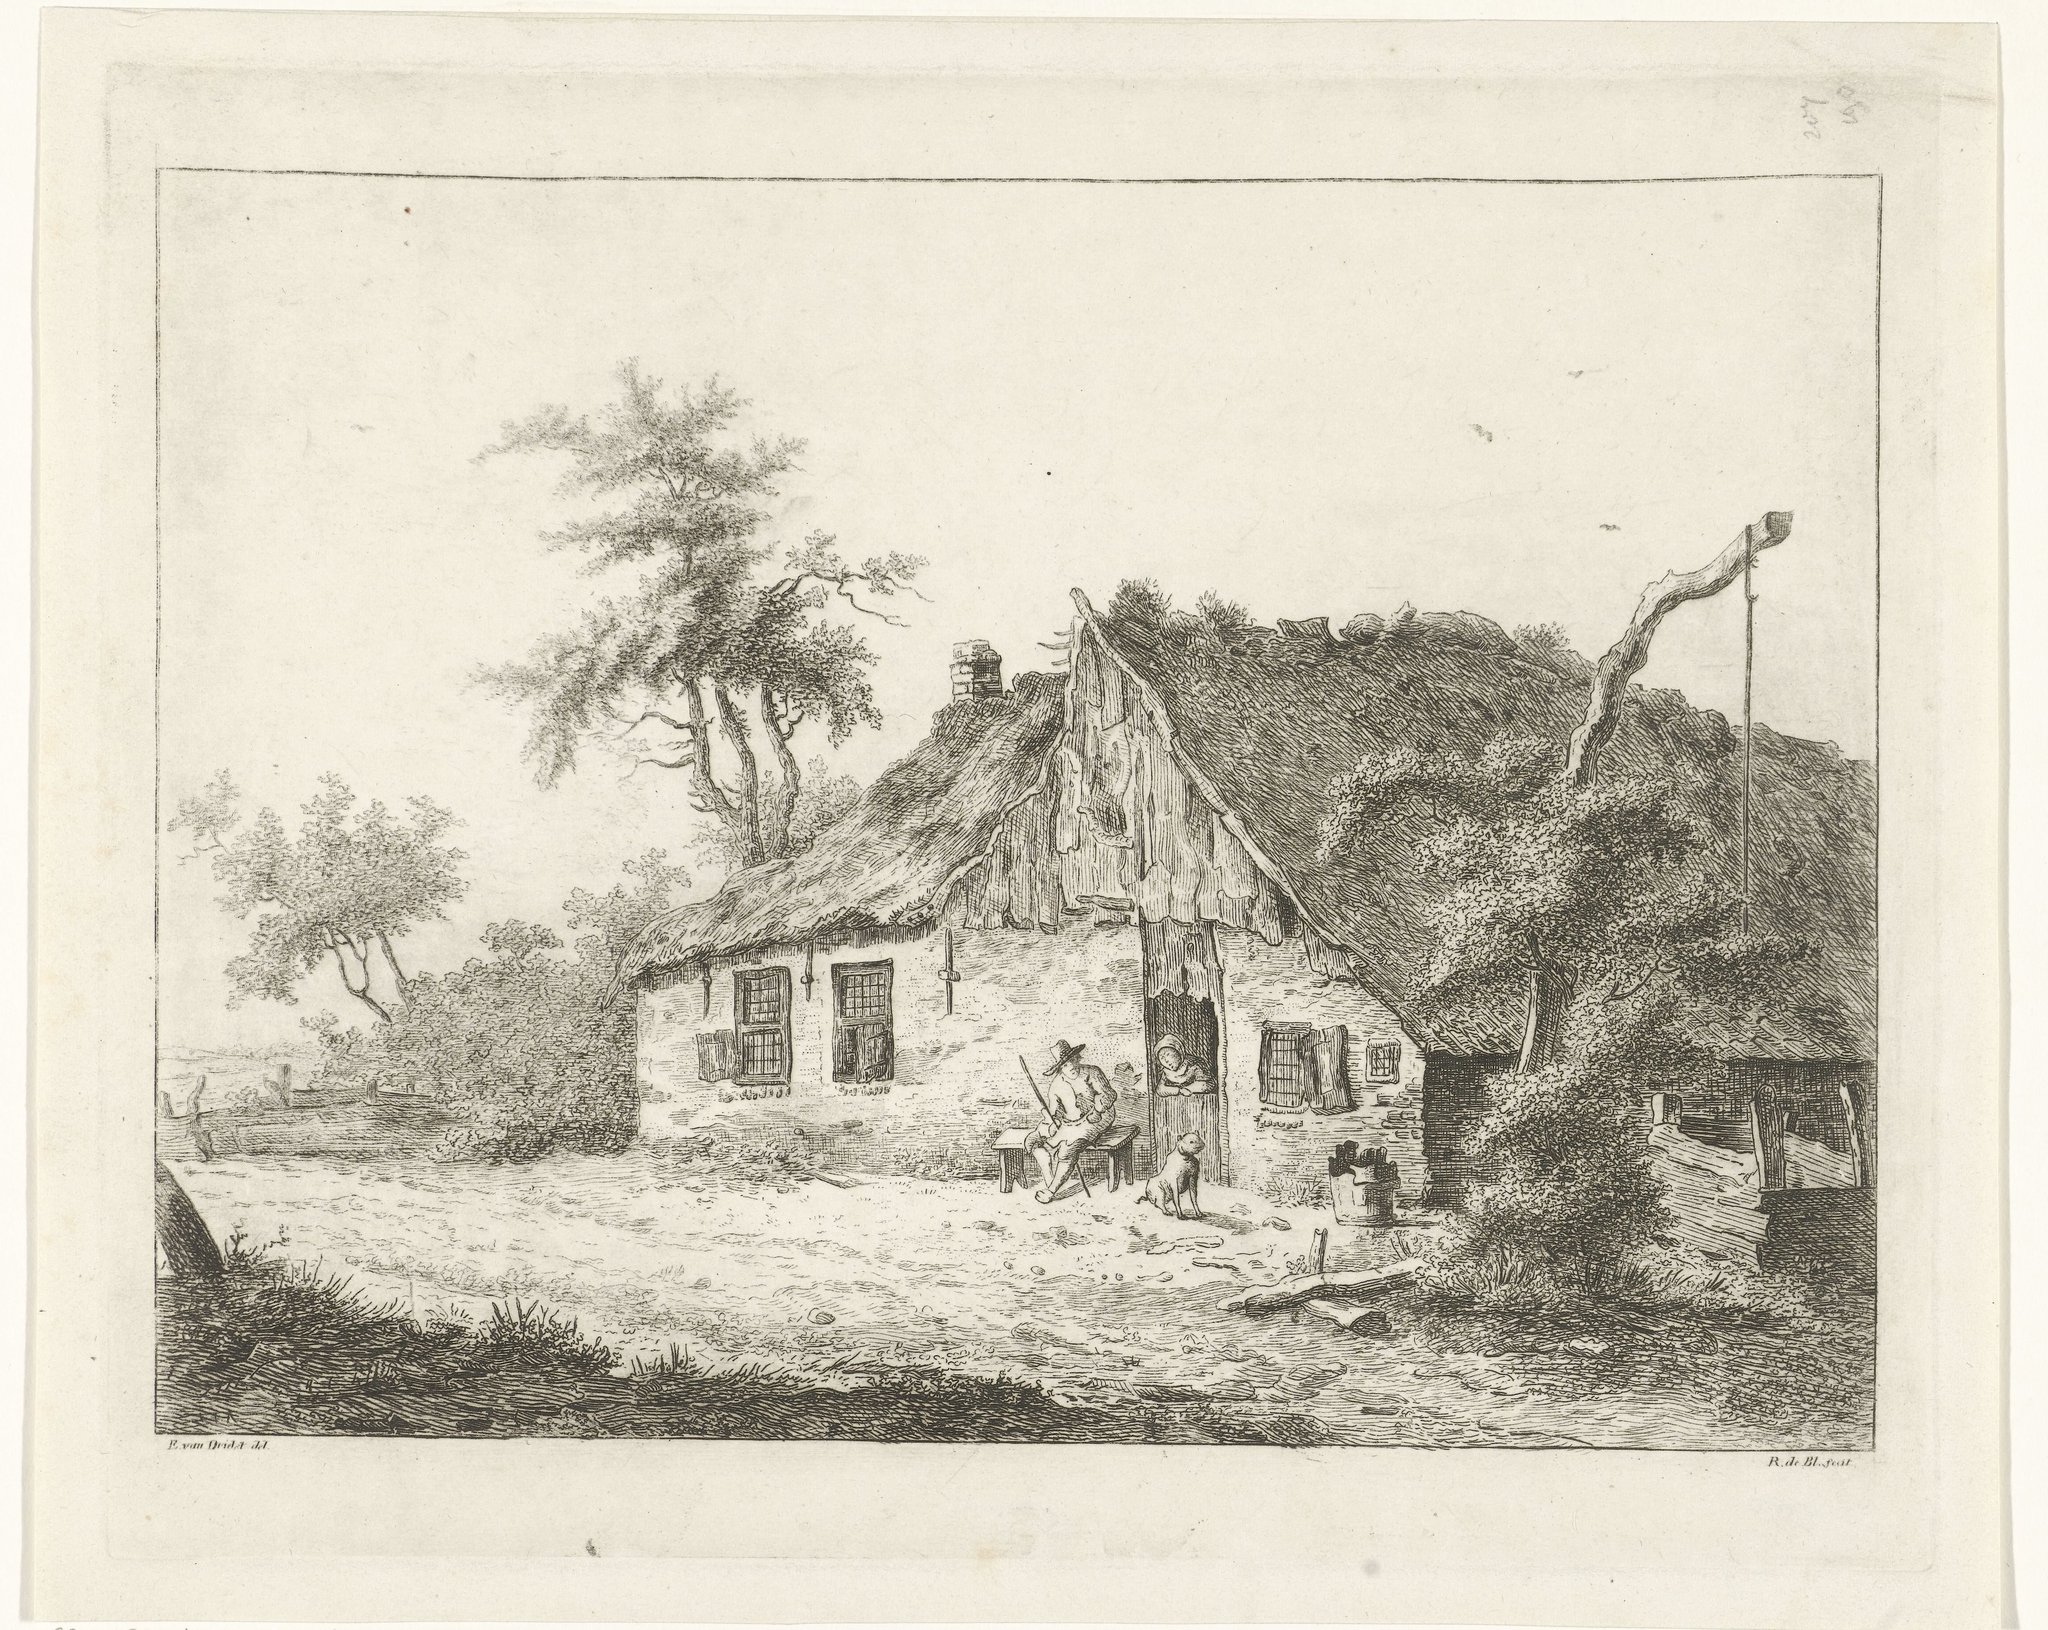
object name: print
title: Boerderij met boer en boerin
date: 1796-1856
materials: paper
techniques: etching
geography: vaassen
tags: farmers, farm or solitary house in landscape, dog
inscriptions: collector's mark: Lugt 2228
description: Een boerderij met een dak van stro. Een boerin staat geleund op de onderdeur. Naast de deur een boer zittend op een bankje en een hond.